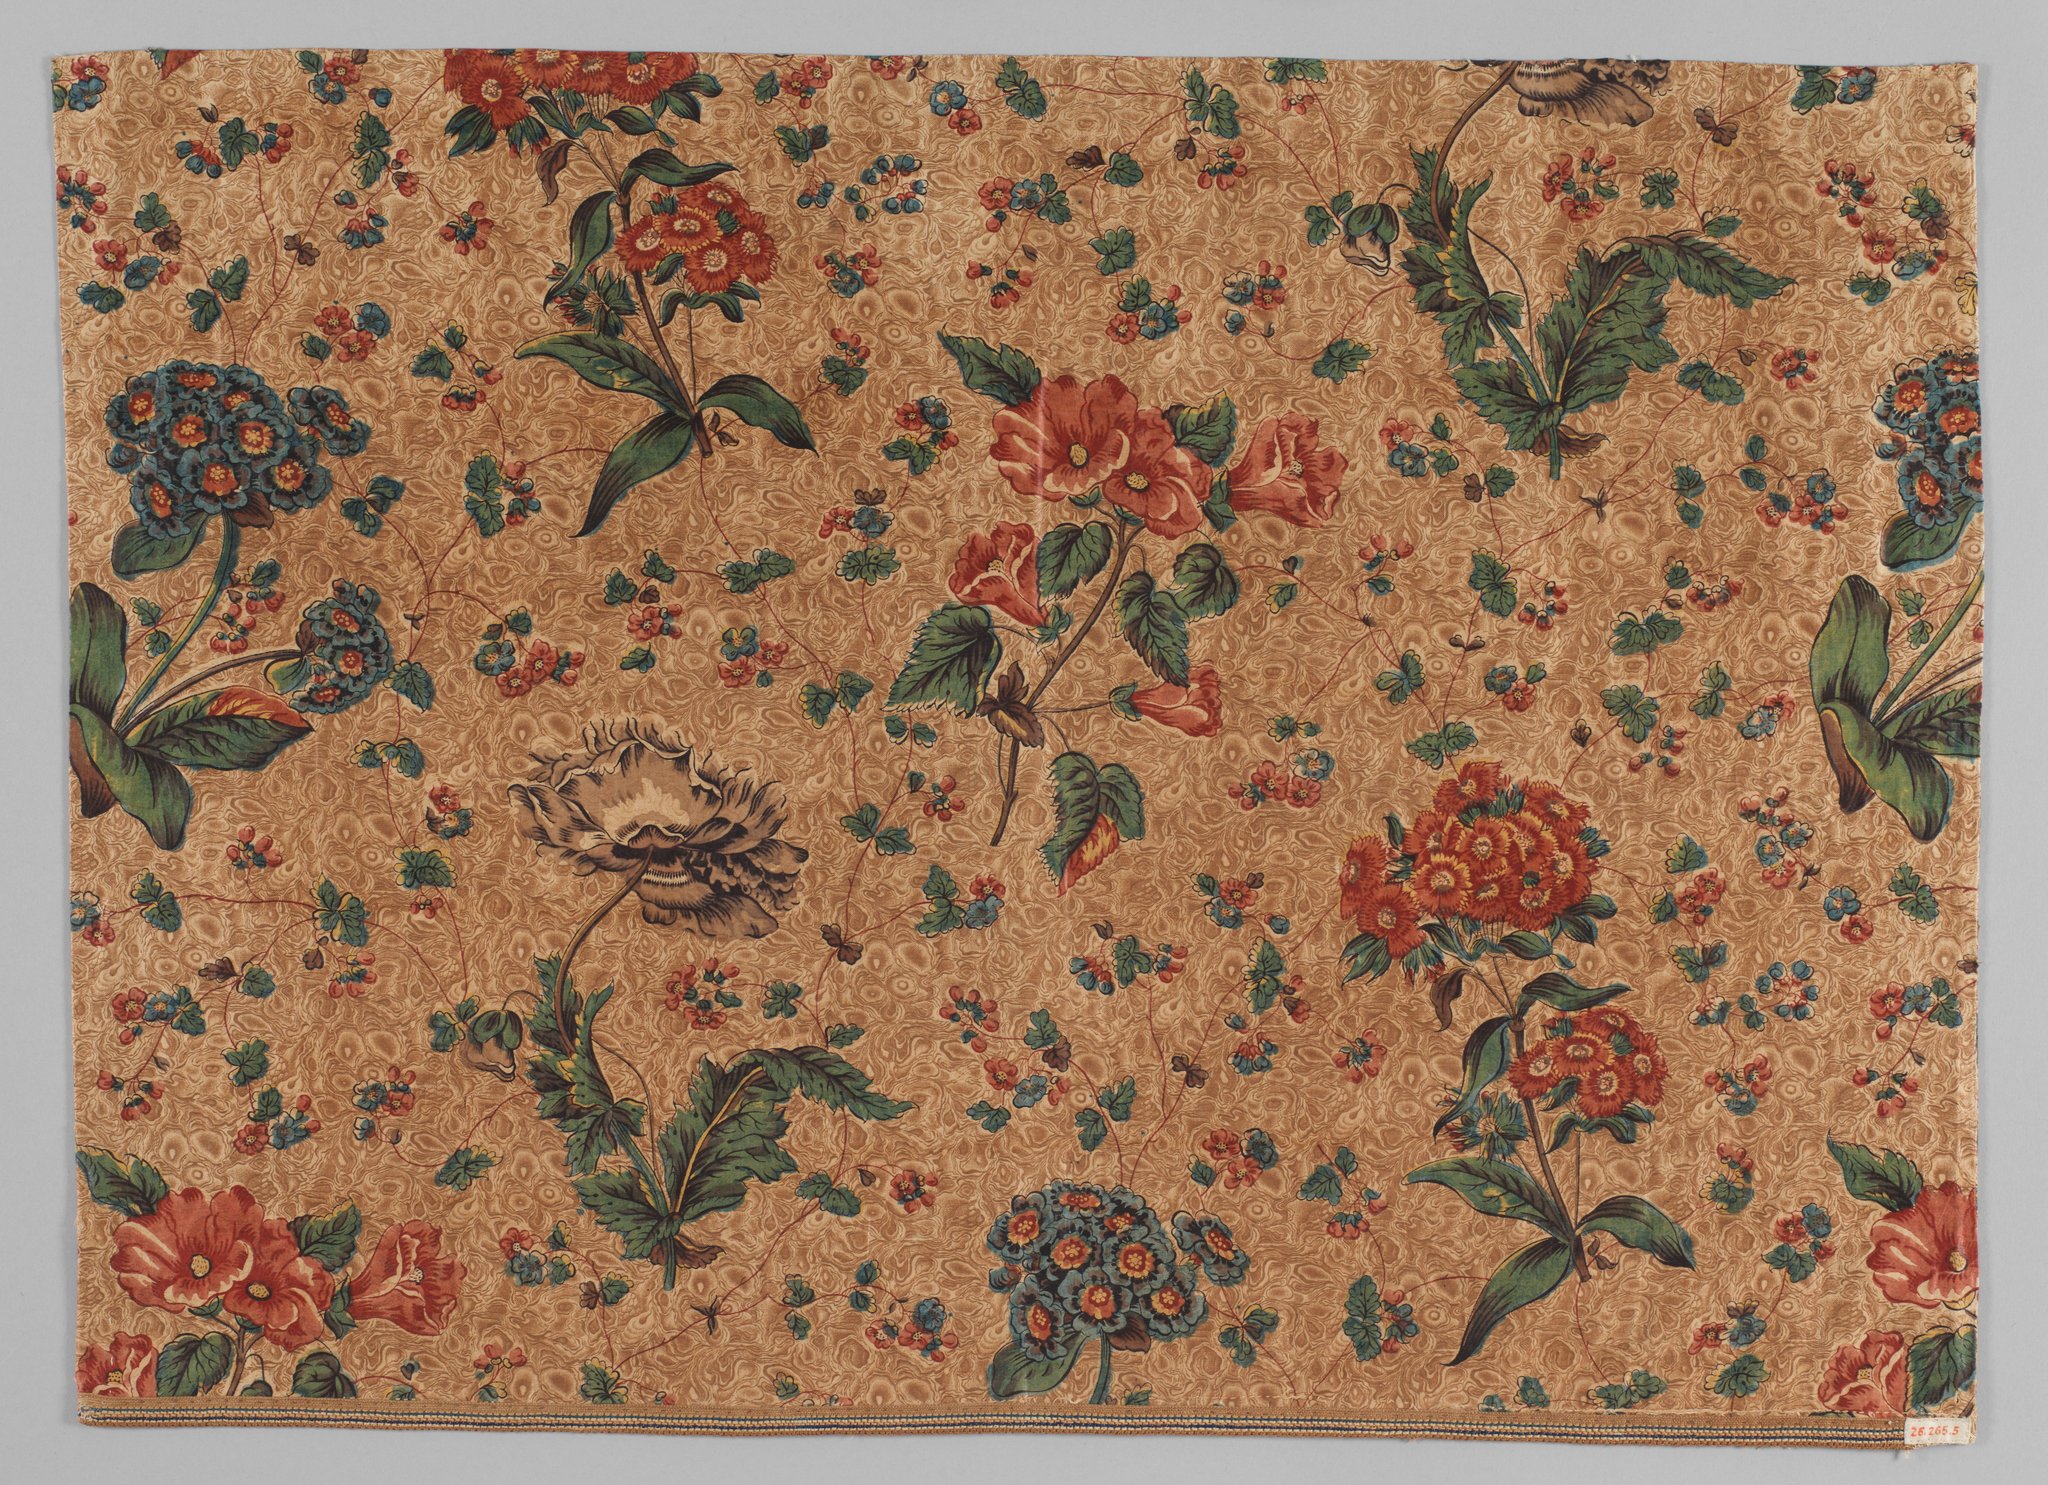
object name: piece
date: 1830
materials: cotton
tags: flowers